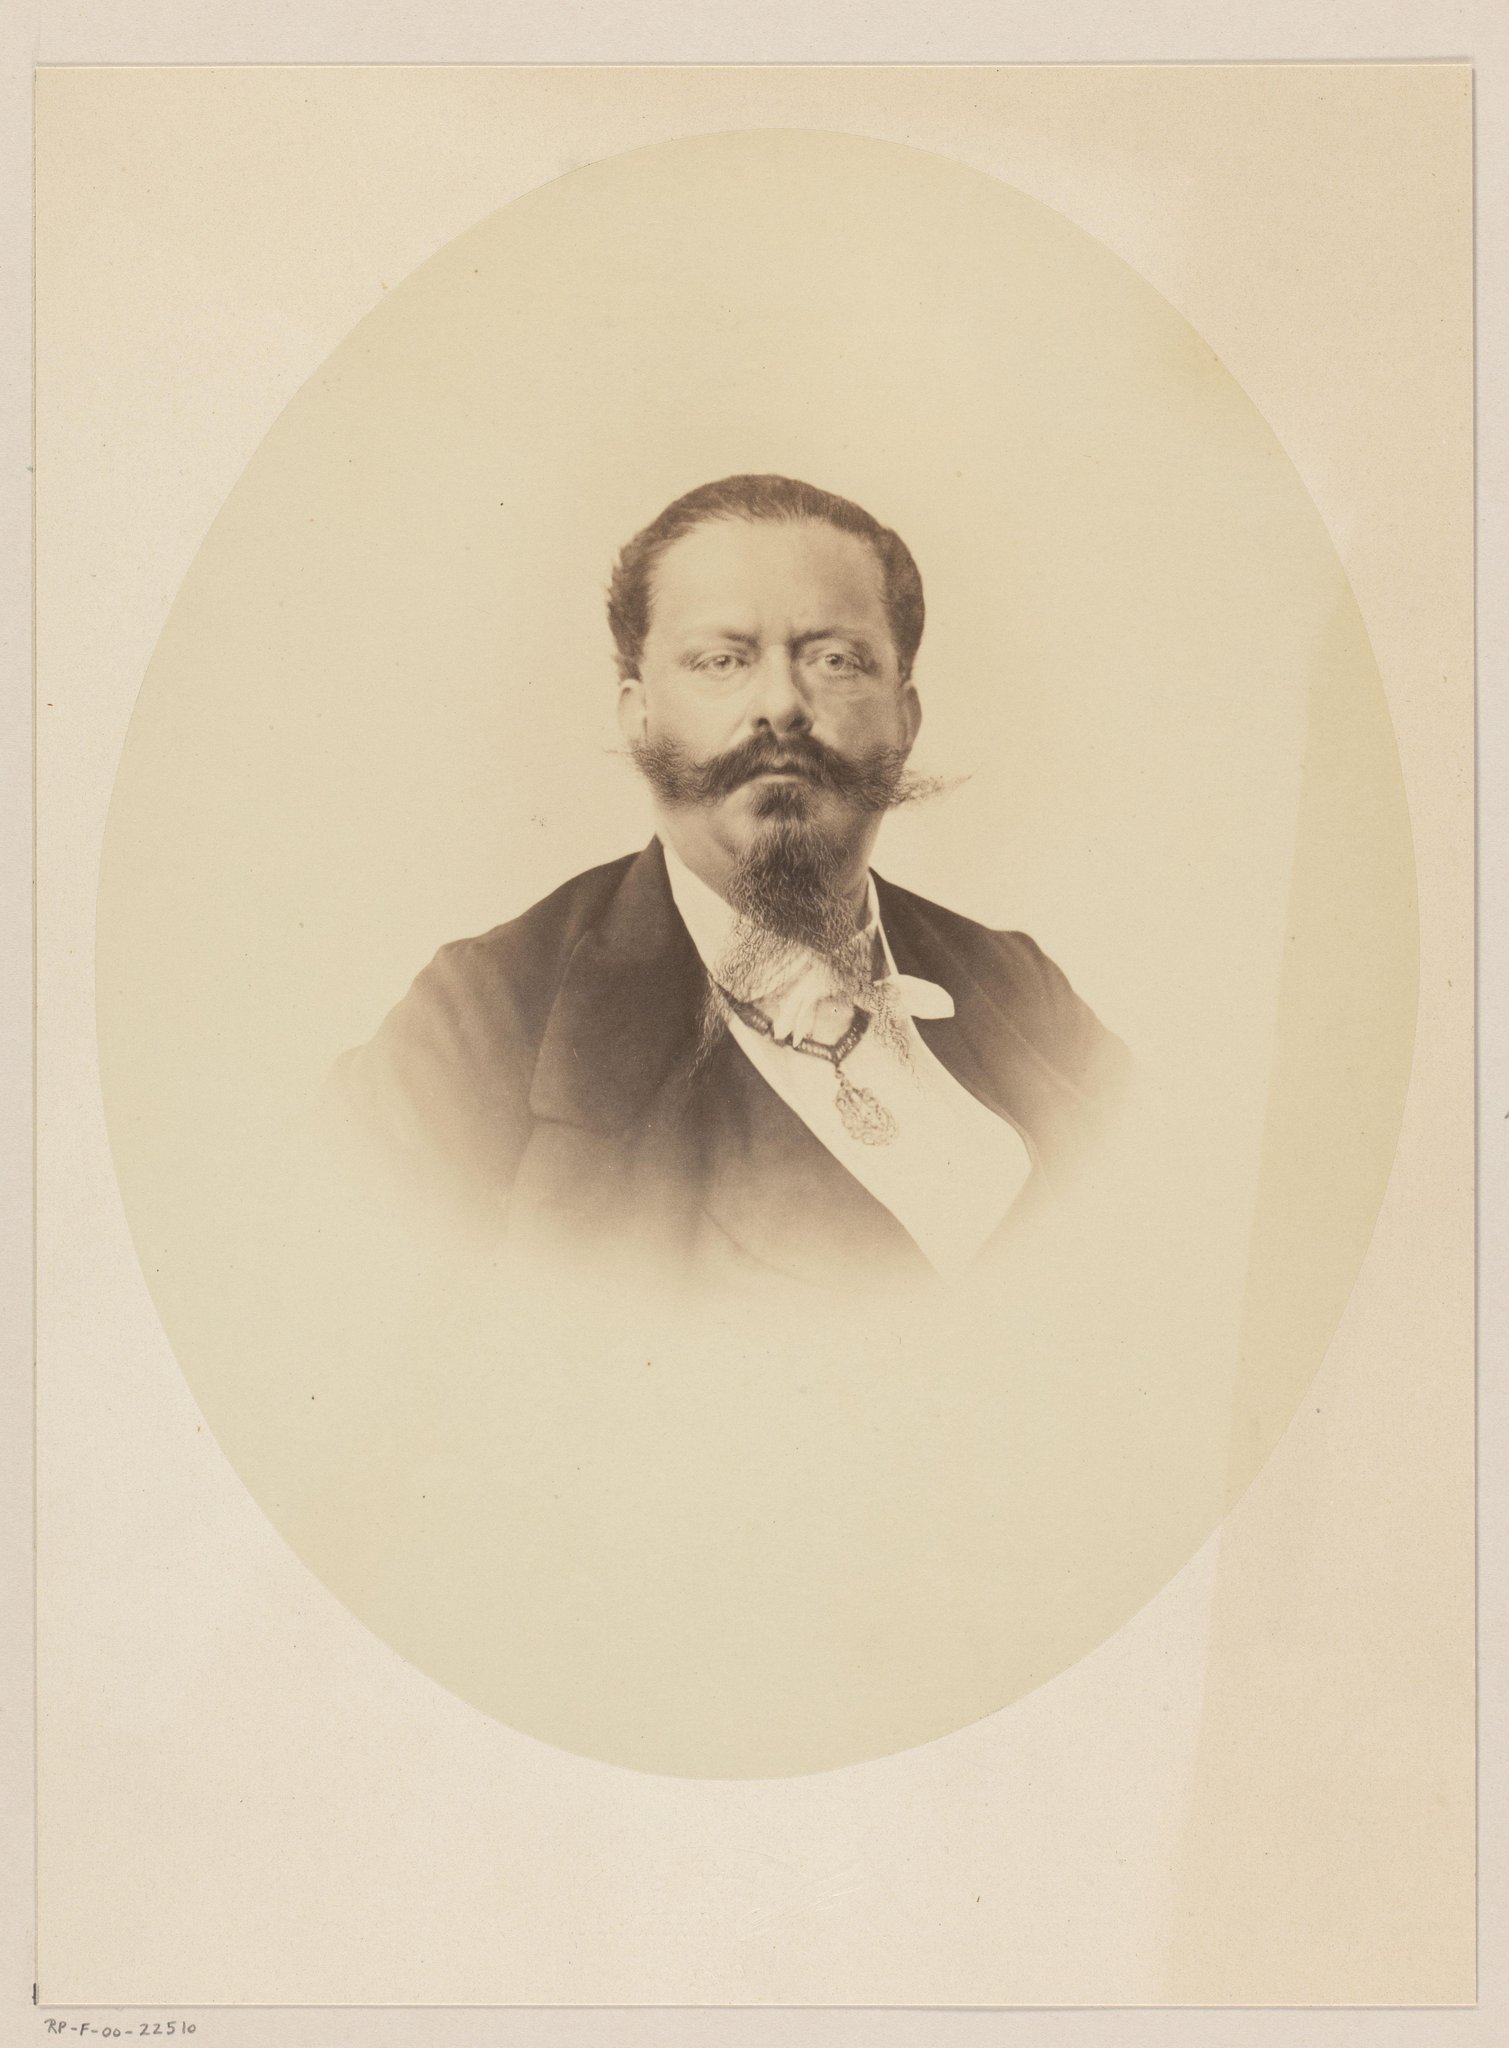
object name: photograph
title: Portret van Victor Emanuel II, koning van Italië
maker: Anonymous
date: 1865-1878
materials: cardboard, paper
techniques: albumen print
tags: historical persons, king